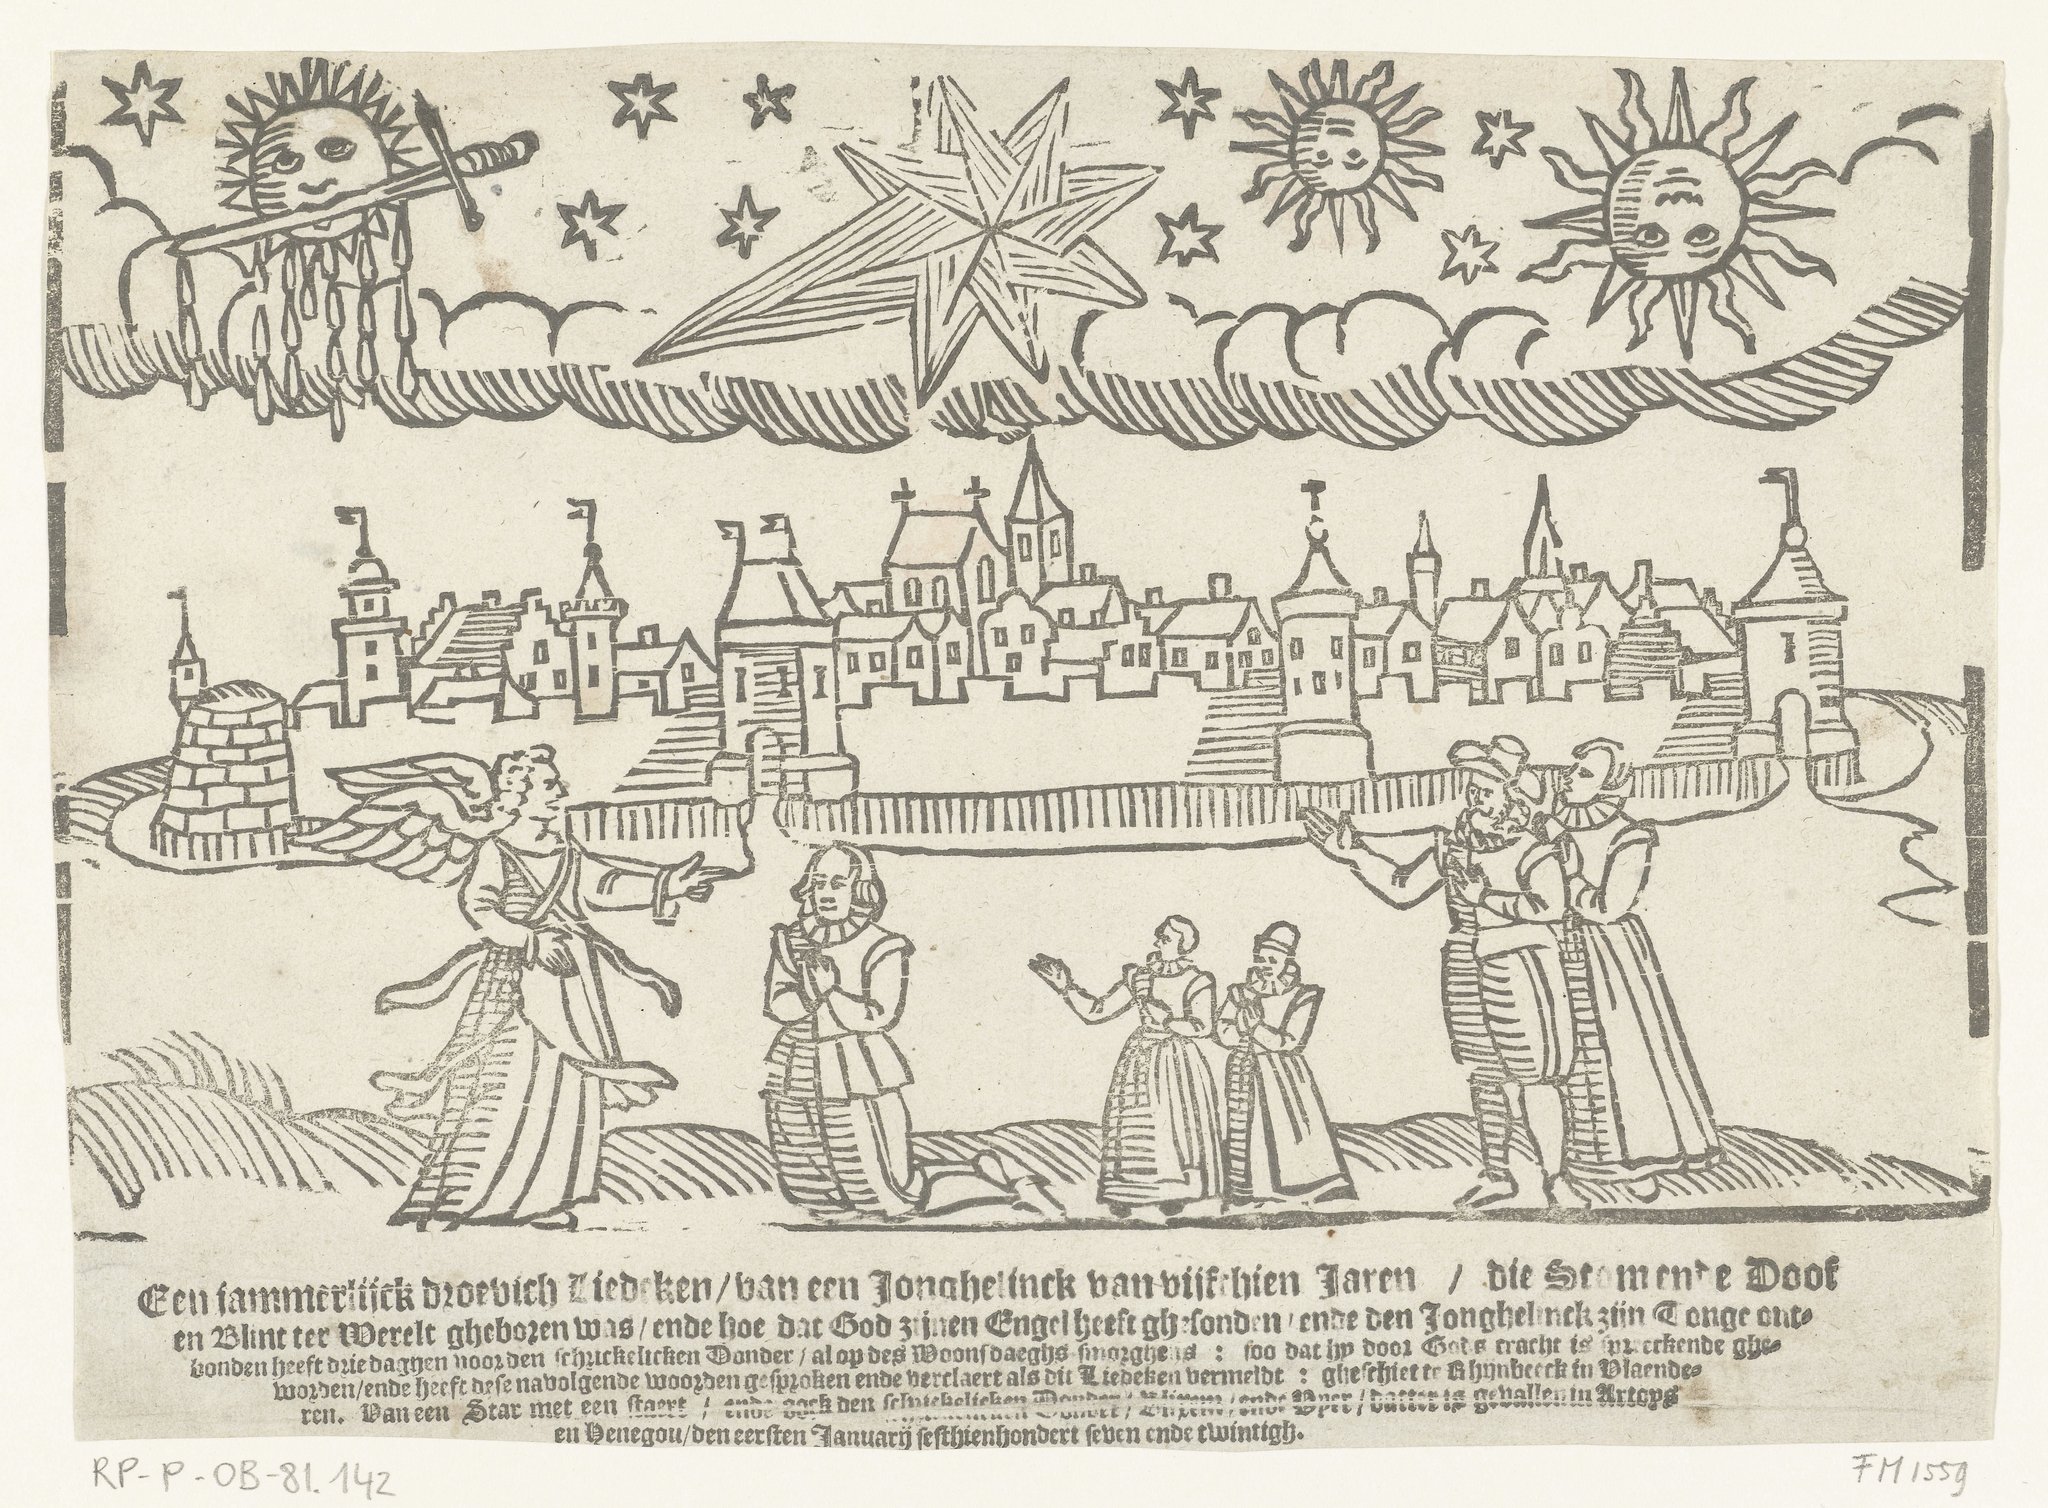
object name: print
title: Staartster en de wonderbaarlijke genezing van een doofblinde jongen, 1627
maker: Anonymous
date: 1627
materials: paper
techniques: letterpress printing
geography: northern netherlands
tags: magic healings, unusual solar phenomena: parhelion or mock sun, spots on solar halo, etc., deaf and non-verbal, formerly known as 'deaf-mute', deaf, deafness, blind, blindness, comet, being silent, henegouwen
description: De wonderbaarlijke genezing van een dove en blinde jongen die niet kon spreken, te Rhijnbeeck in Vlaanderen, die zijn spraakvermogen herkreeg drie dagen voor het verschrikkelijke onweer van 1 januari 1627 te Artois en Henegouwen. De jongeman knielend voor een engel met uitgestoken hand, rechts zijn ouders. Op de achtergrond een ommuurde stad met in de hemel een zon met een bloedend zwaard in de mond, de staartster of komeet en twee omgekeerde manen (of zonnen).